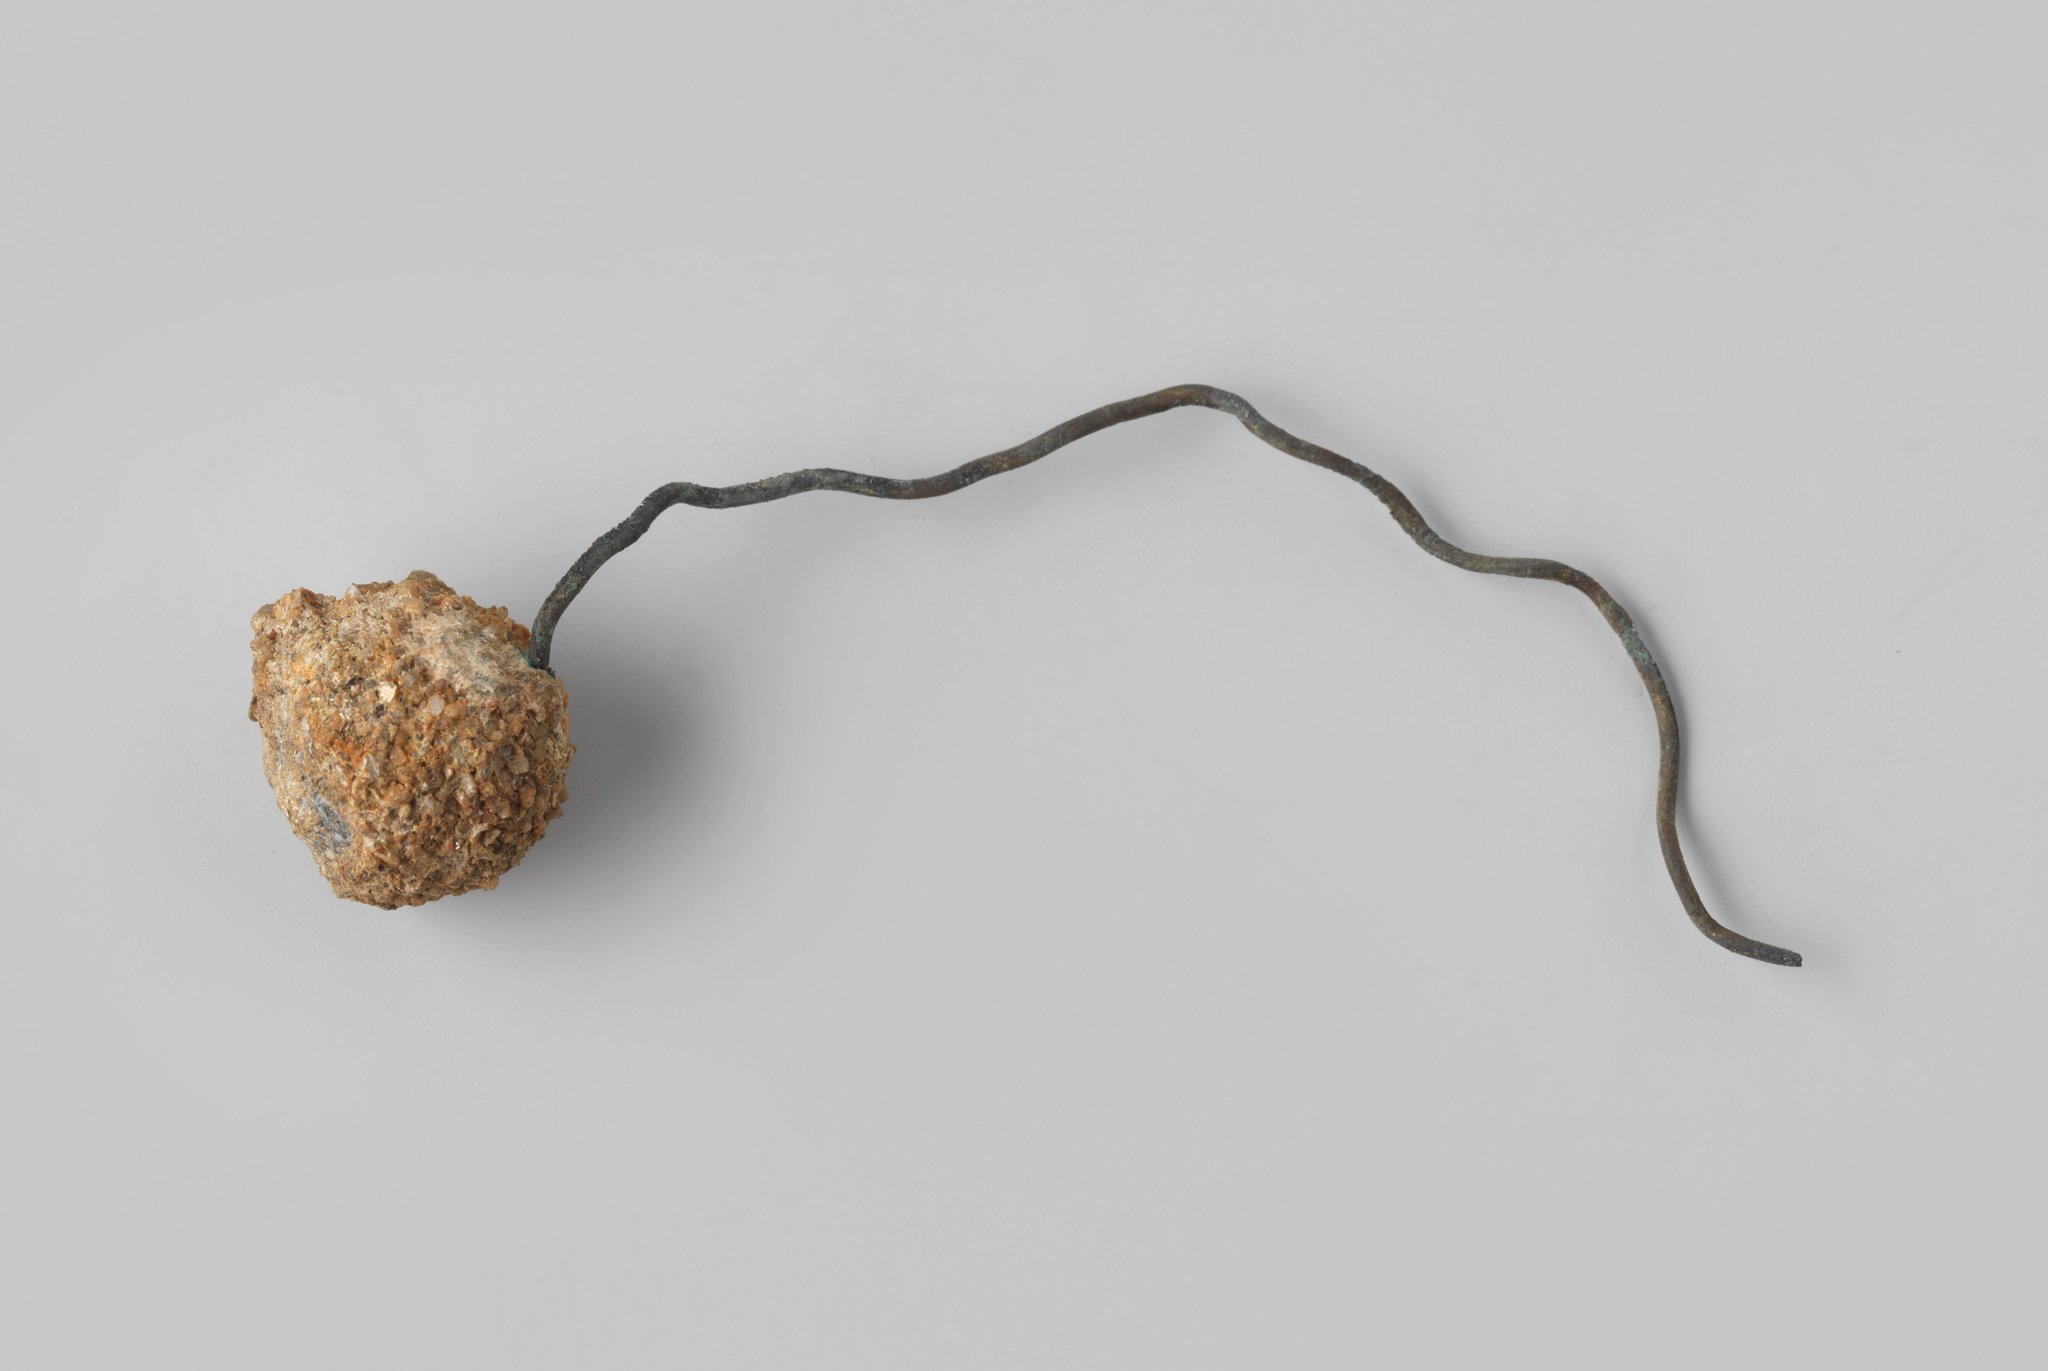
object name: chain shot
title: Kettingkogel uit het wrak van de Oost-Indiëvaarder Hollandia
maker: Anonymous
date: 1700-1743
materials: lead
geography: netherlands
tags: verenigde oostindische compagnie, hollandia (schip), annet